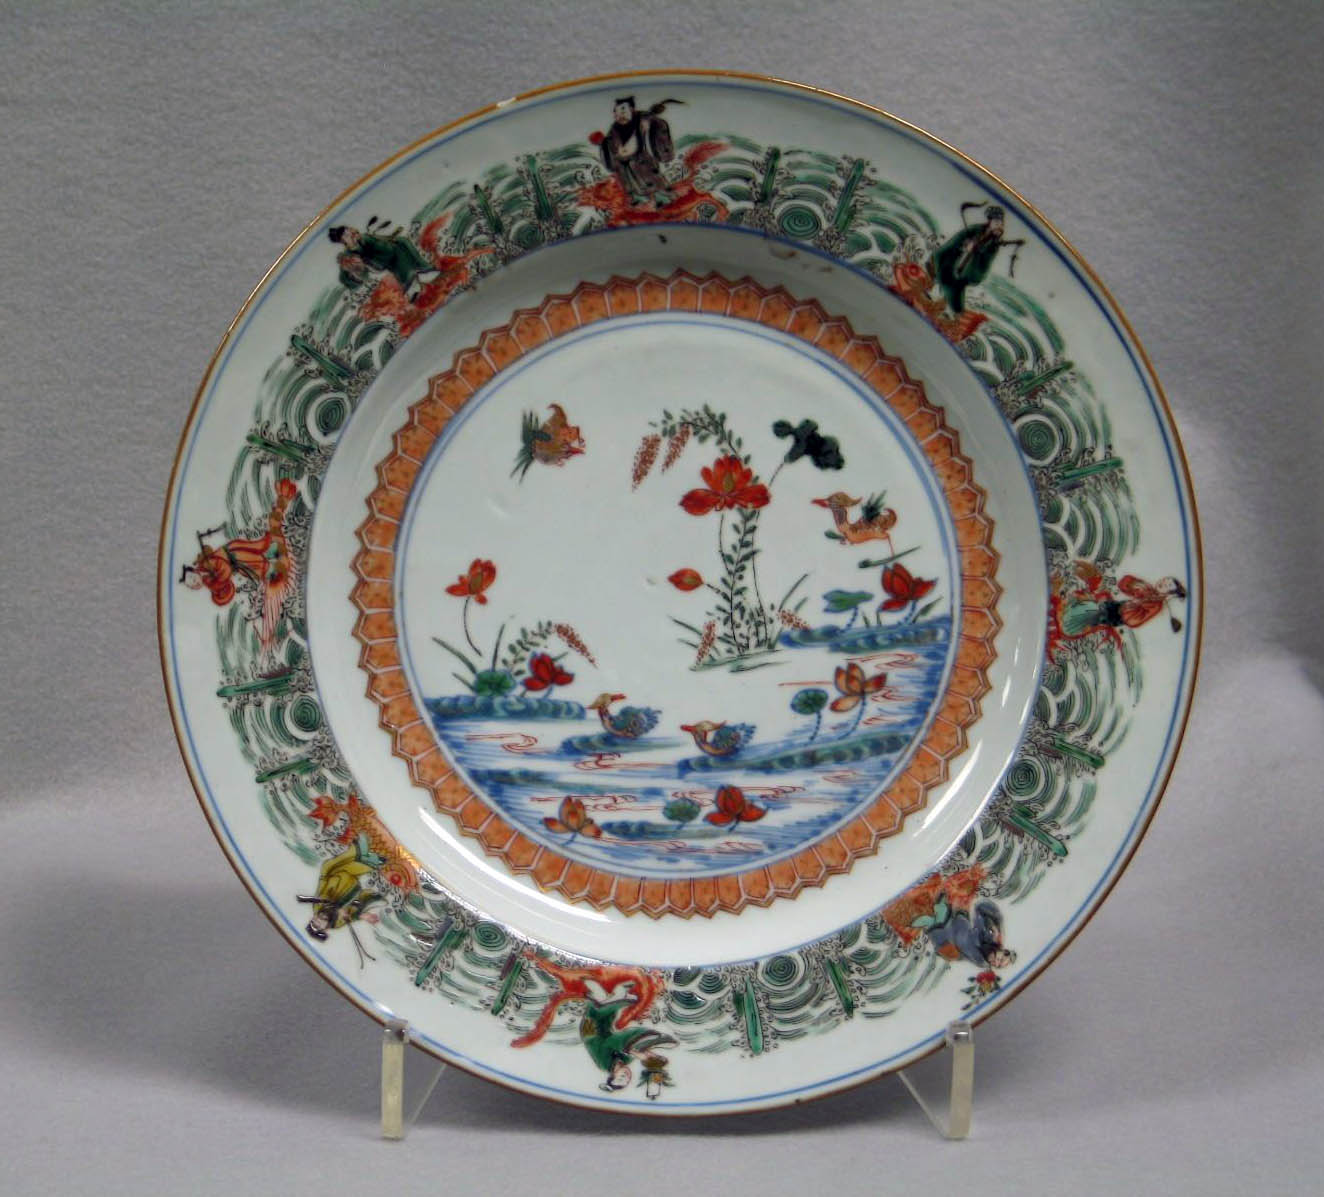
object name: plate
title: Plate with lotus pond and Daoist immortals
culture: chinese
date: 1644-1911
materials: enamel, porcelain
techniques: overglaze, painting, underglaze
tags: birds,lotuses